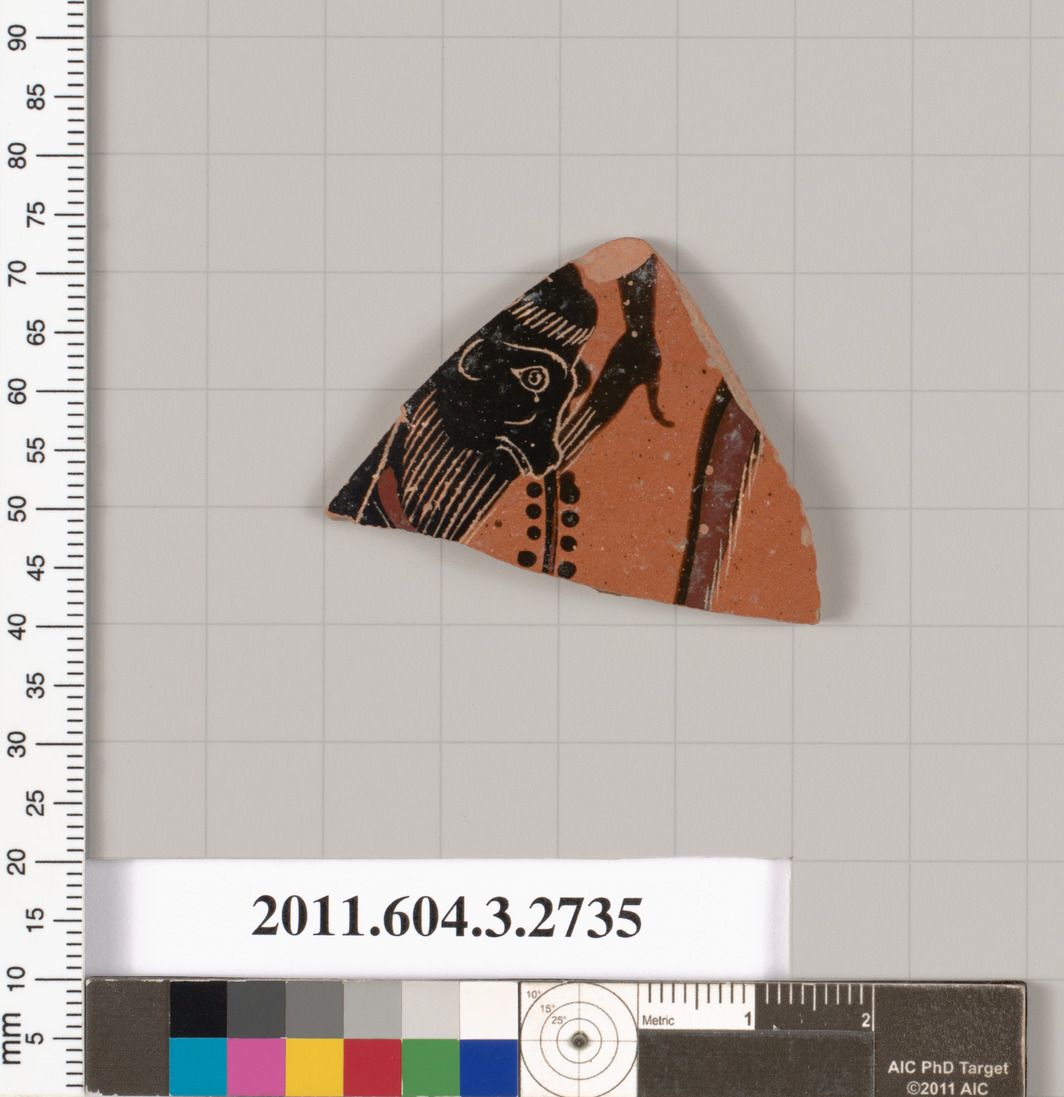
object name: olpe fragment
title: Terracotta fragment of an olpe (jug)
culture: greek, attic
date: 530-520 BCE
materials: terracotta